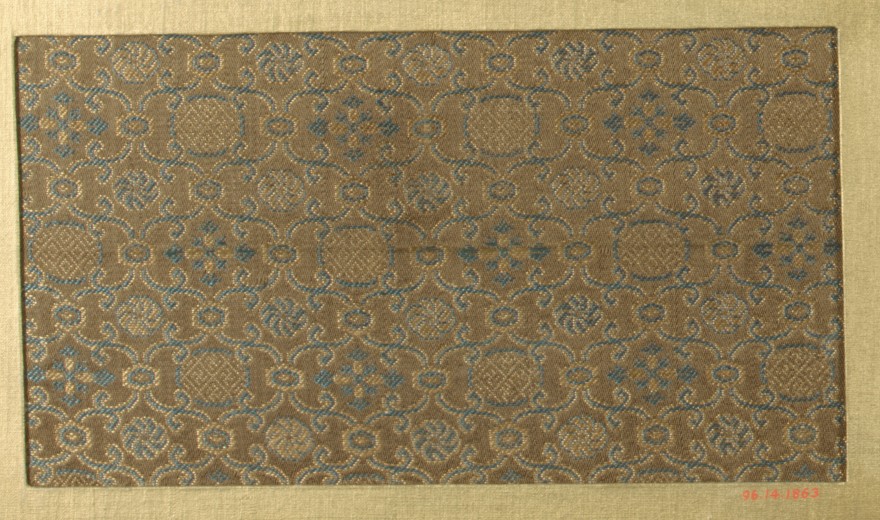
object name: piece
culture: japanese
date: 1701-1900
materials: silk